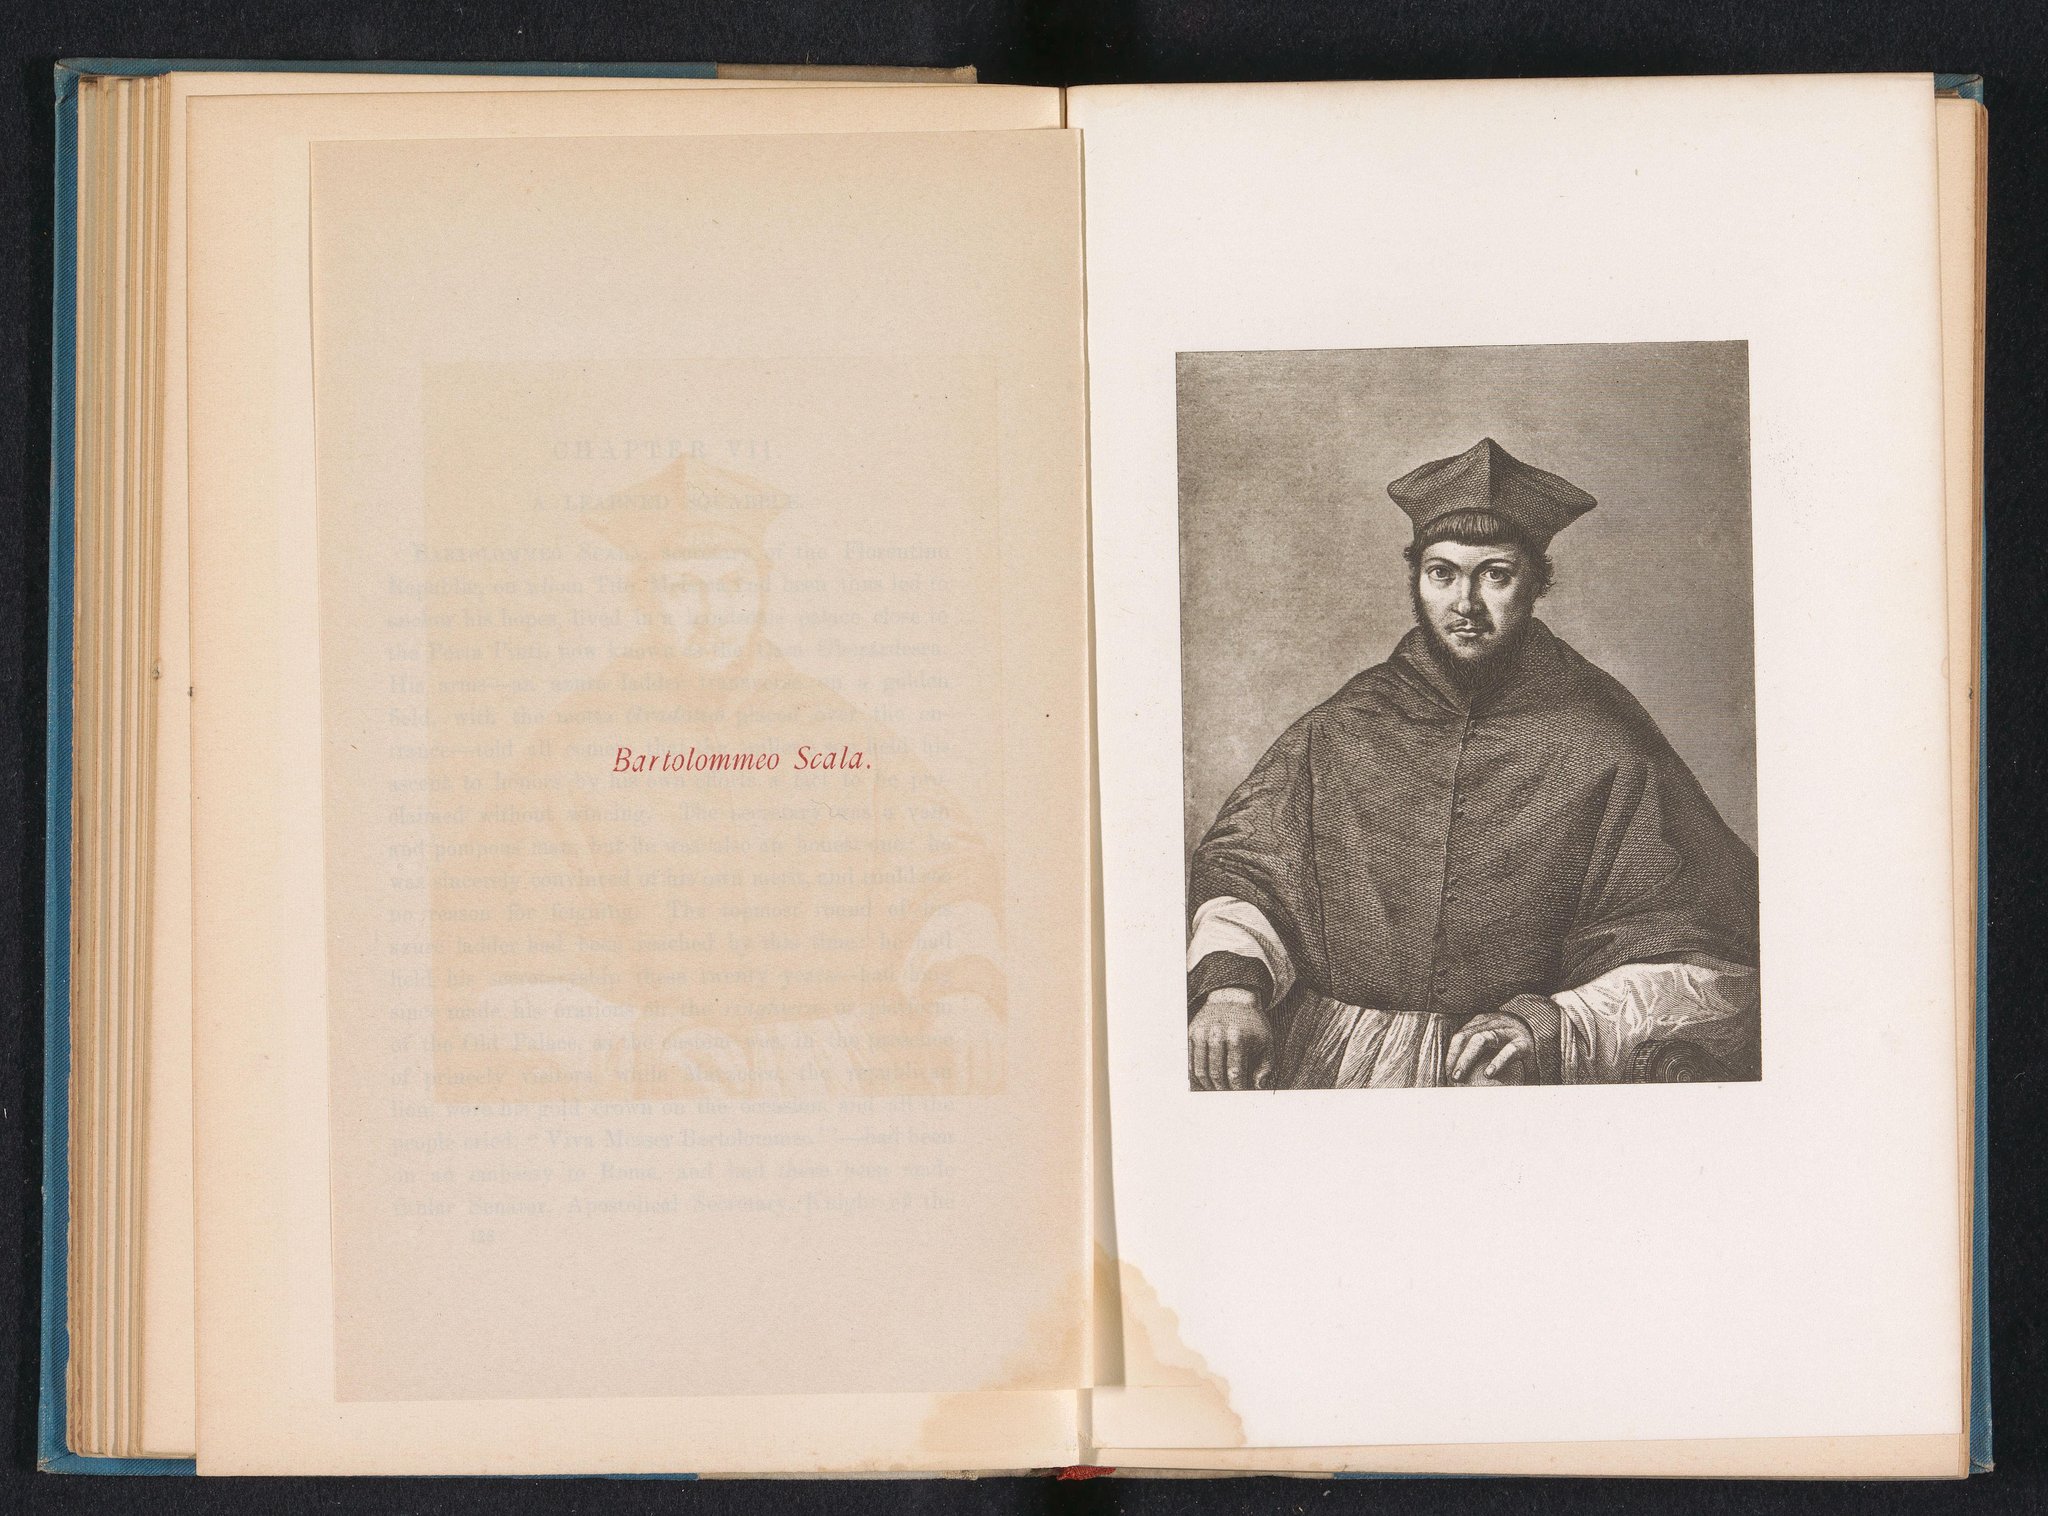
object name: photomechanical print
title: Fotoreproductie van een prent, voorstellende een portret van Bartolommeo Scala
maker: Anonymous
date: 1880-1890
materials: paper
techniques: photoaquatint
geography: florence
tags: politician, politician, e.g. party leader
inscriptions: title: ‘Bartolommeo Scala.’